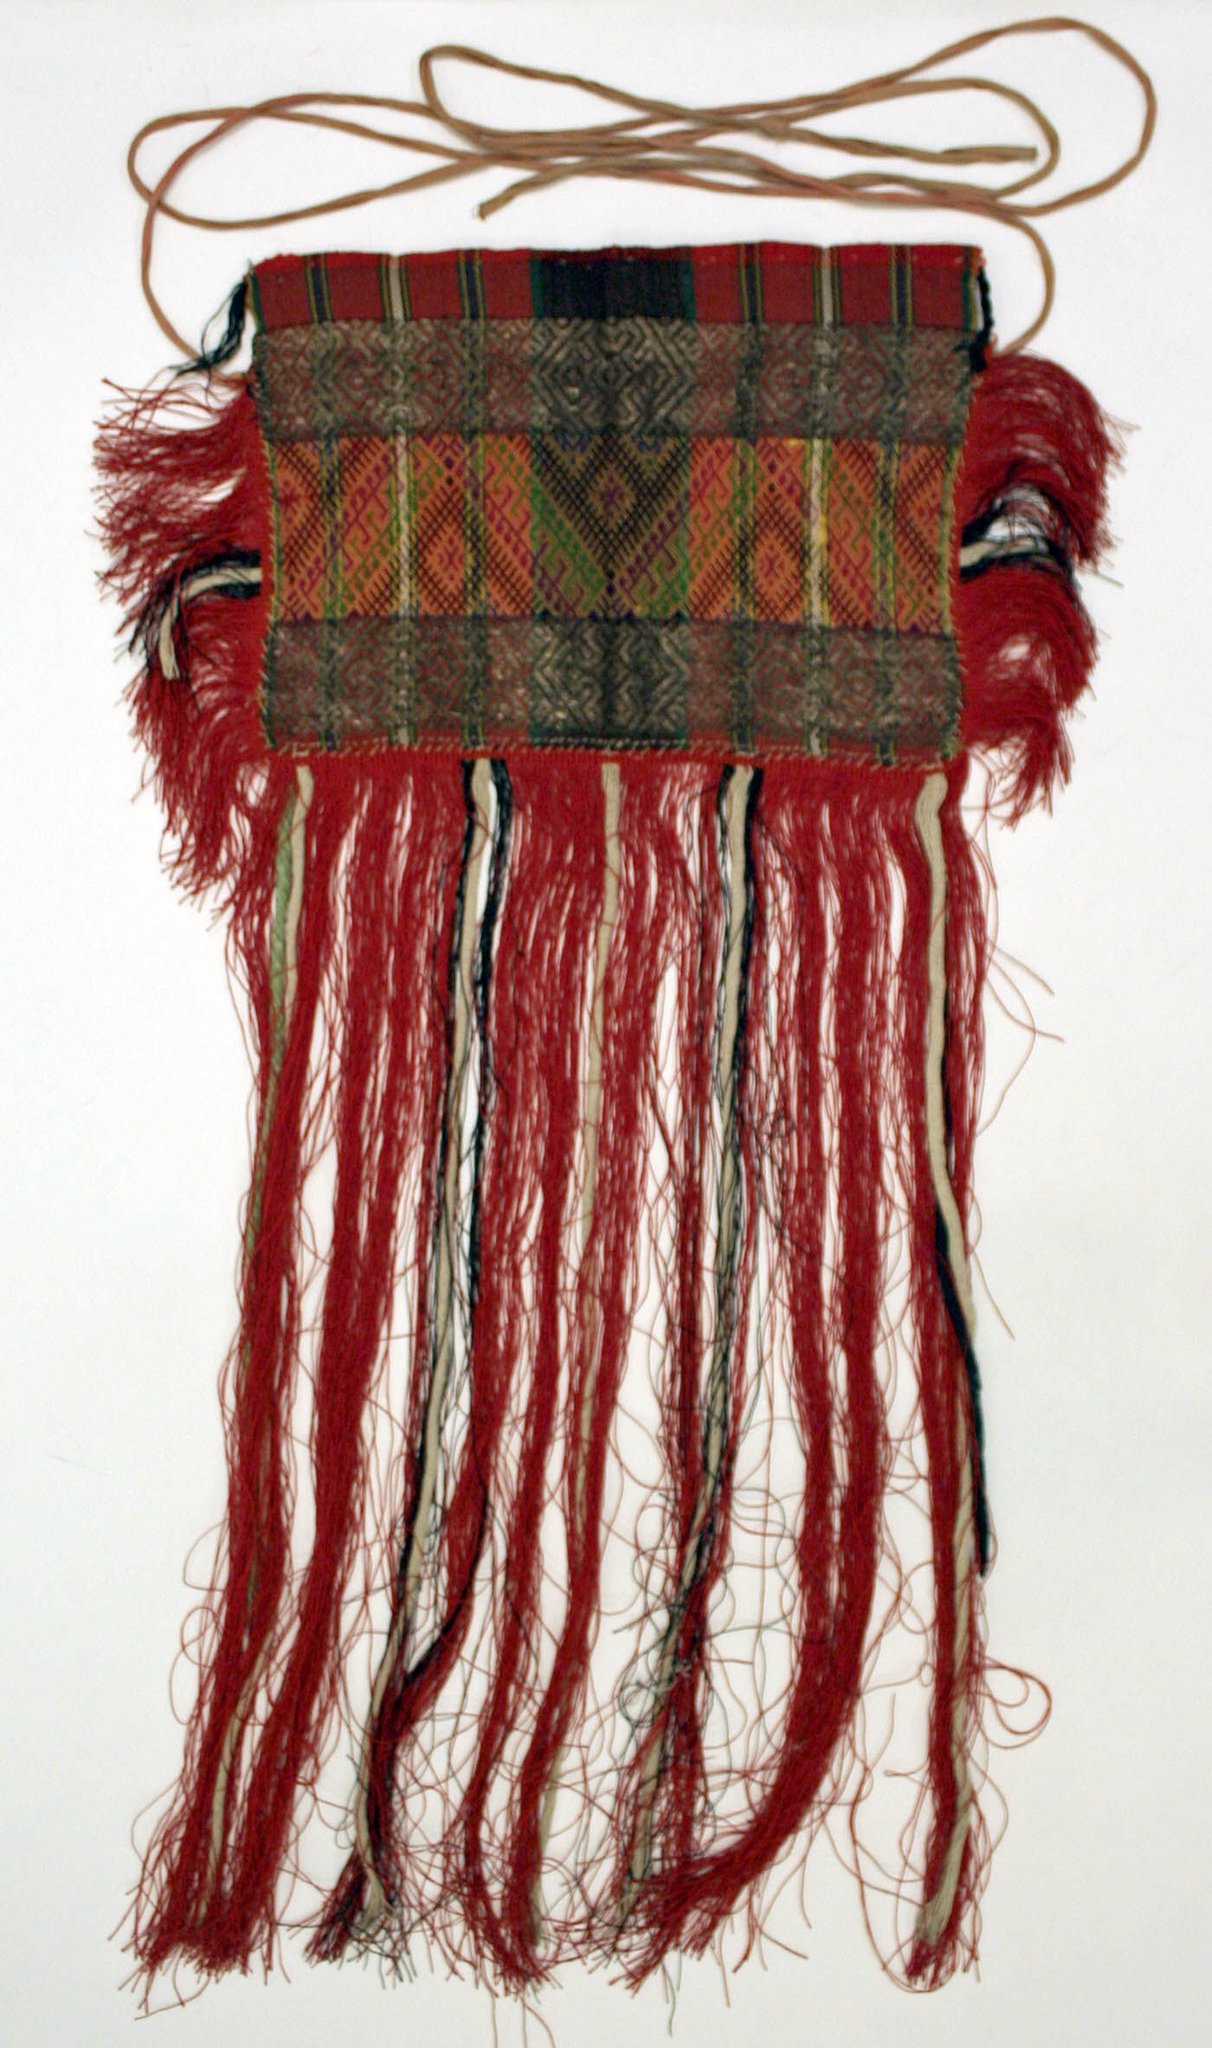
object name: apron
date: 1867-1933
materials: metal thread, wool